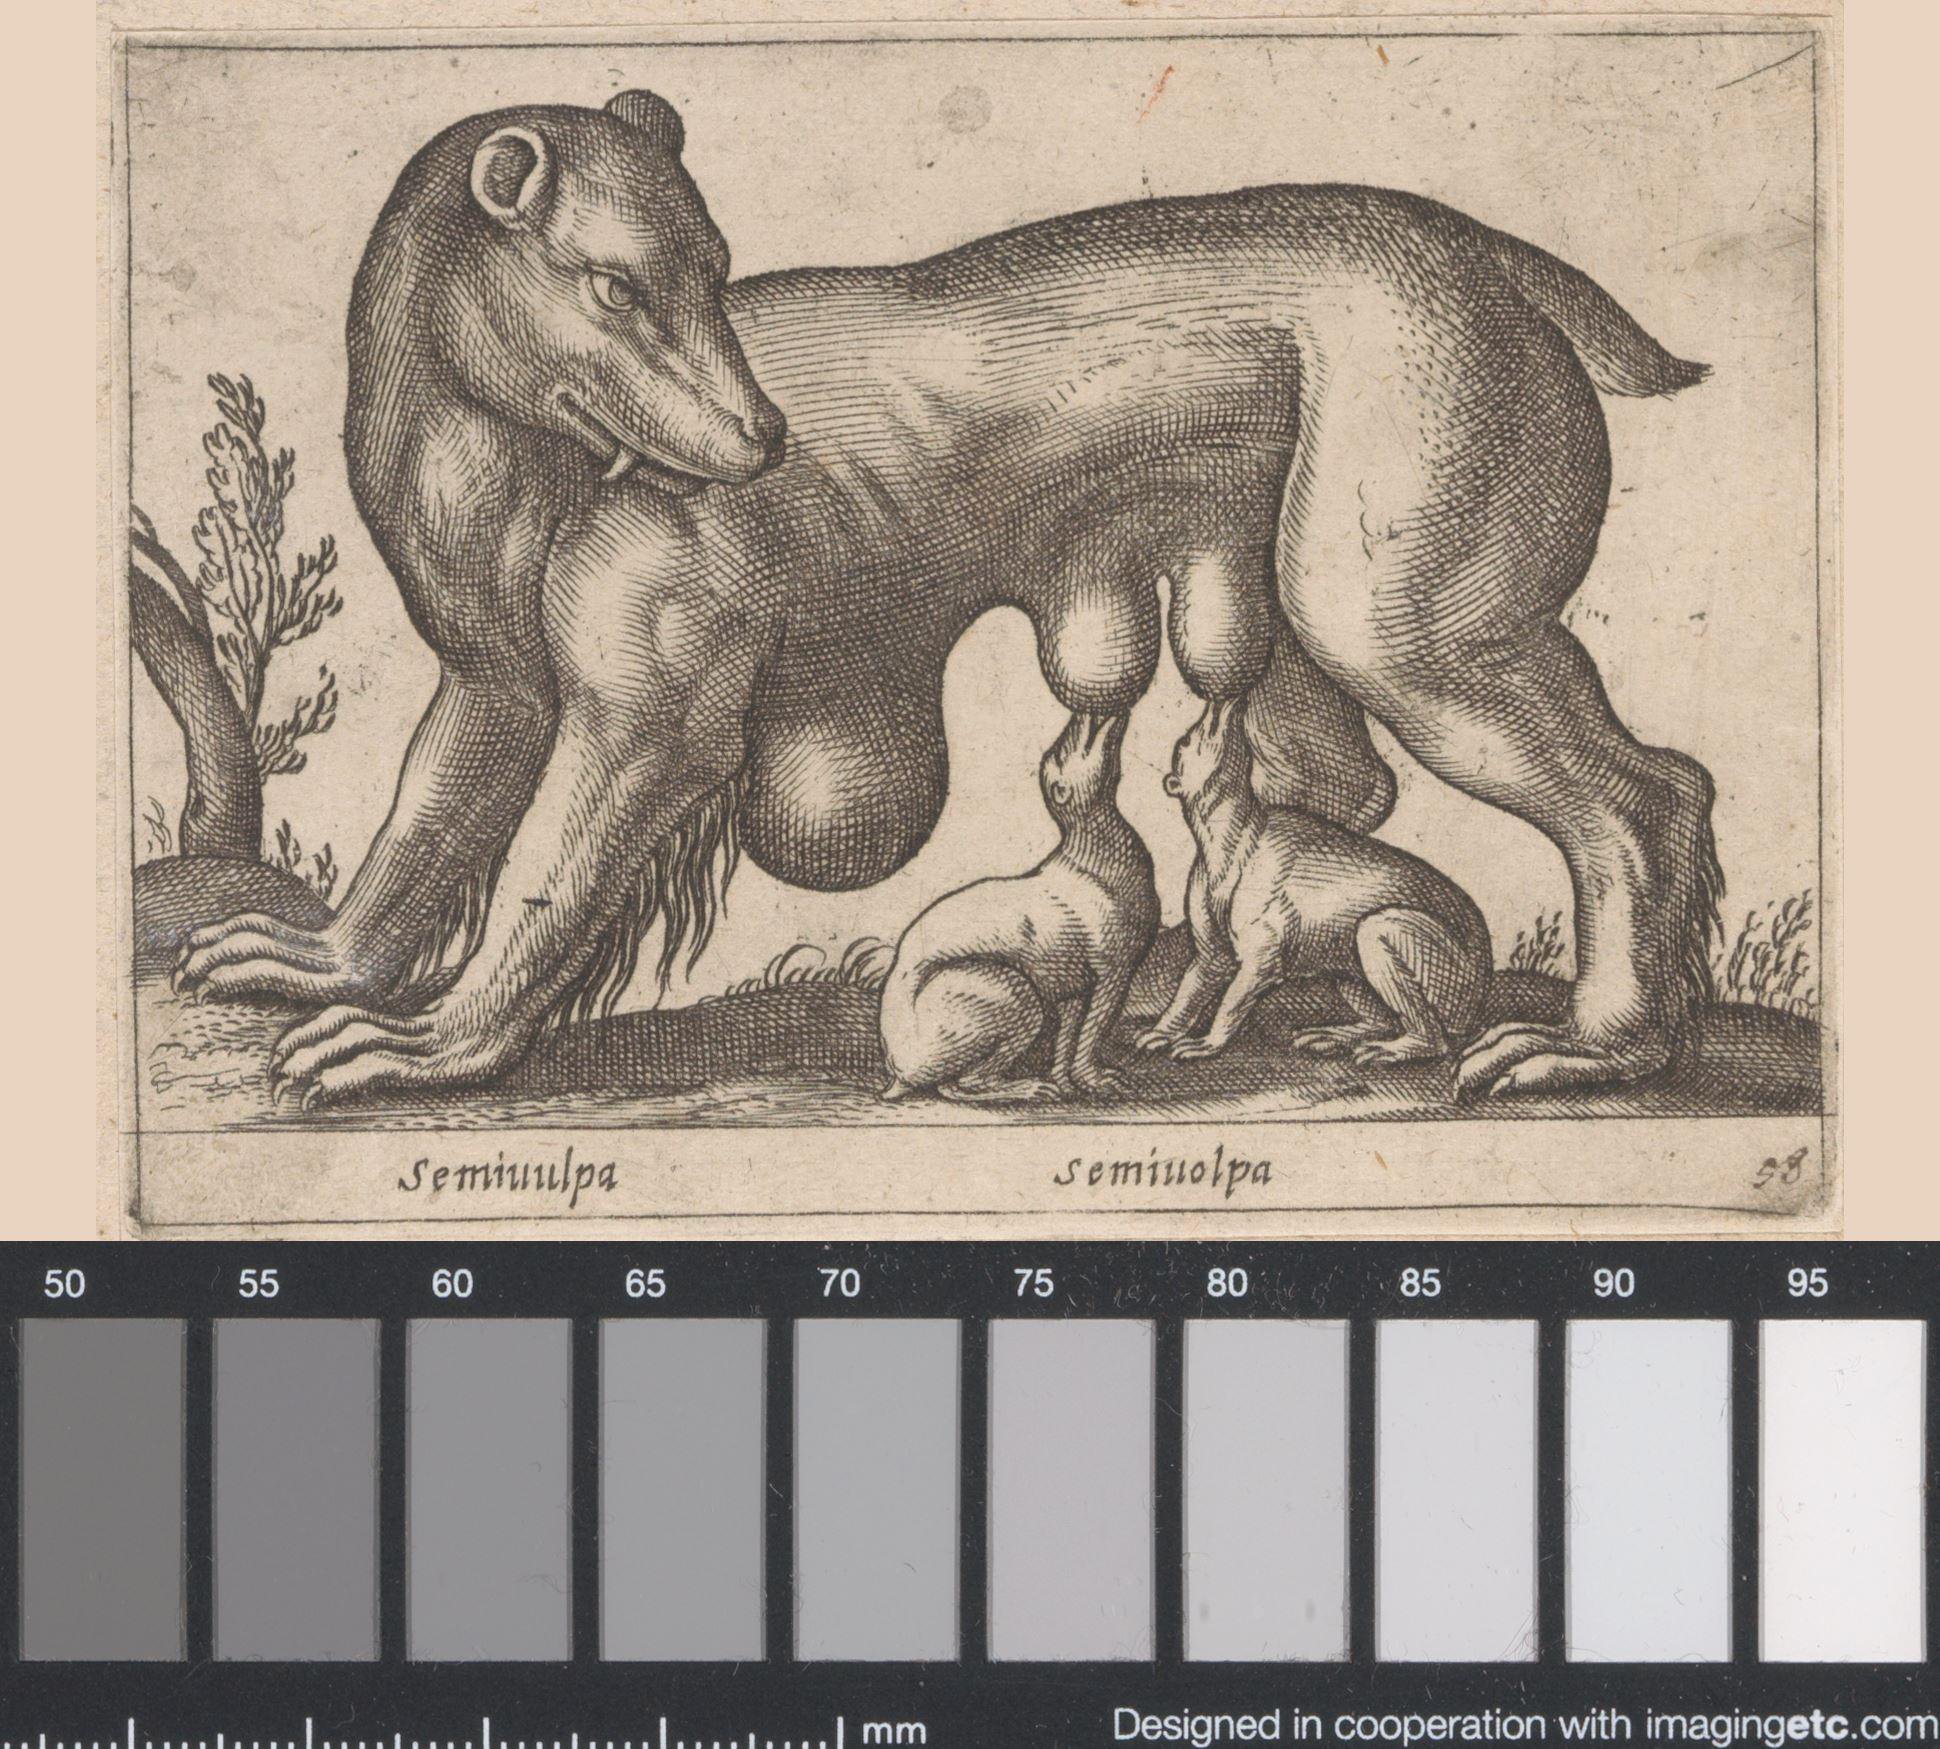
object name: print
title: Nova raccolta de li animali piu curiosi del mondo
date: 1565-1630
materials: paper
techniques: etching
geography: rome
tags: nursing, suckling, other mammals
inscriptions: number: ‘58’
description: Gebaseerd op Conrad Gessners Historia animalium, waarin hij het dier beschreef als een ‘Vosaap’ (simivulpa), van voren een vos, de achterhelft als een aap. Tegenwoordig wordt het dier aangeduid als buidelrat of opossum. Deze prent maakt deel uit van een reeks prenten van dieren door Antonio Tempesta. Bekend is dat een tweede staat (met nummering) van deze serie is uitgegeven door Giovanni Giacomo de' Rossi in 1650. Onbekend is wie de eerste staat heeft uitgegeven en wanneer.